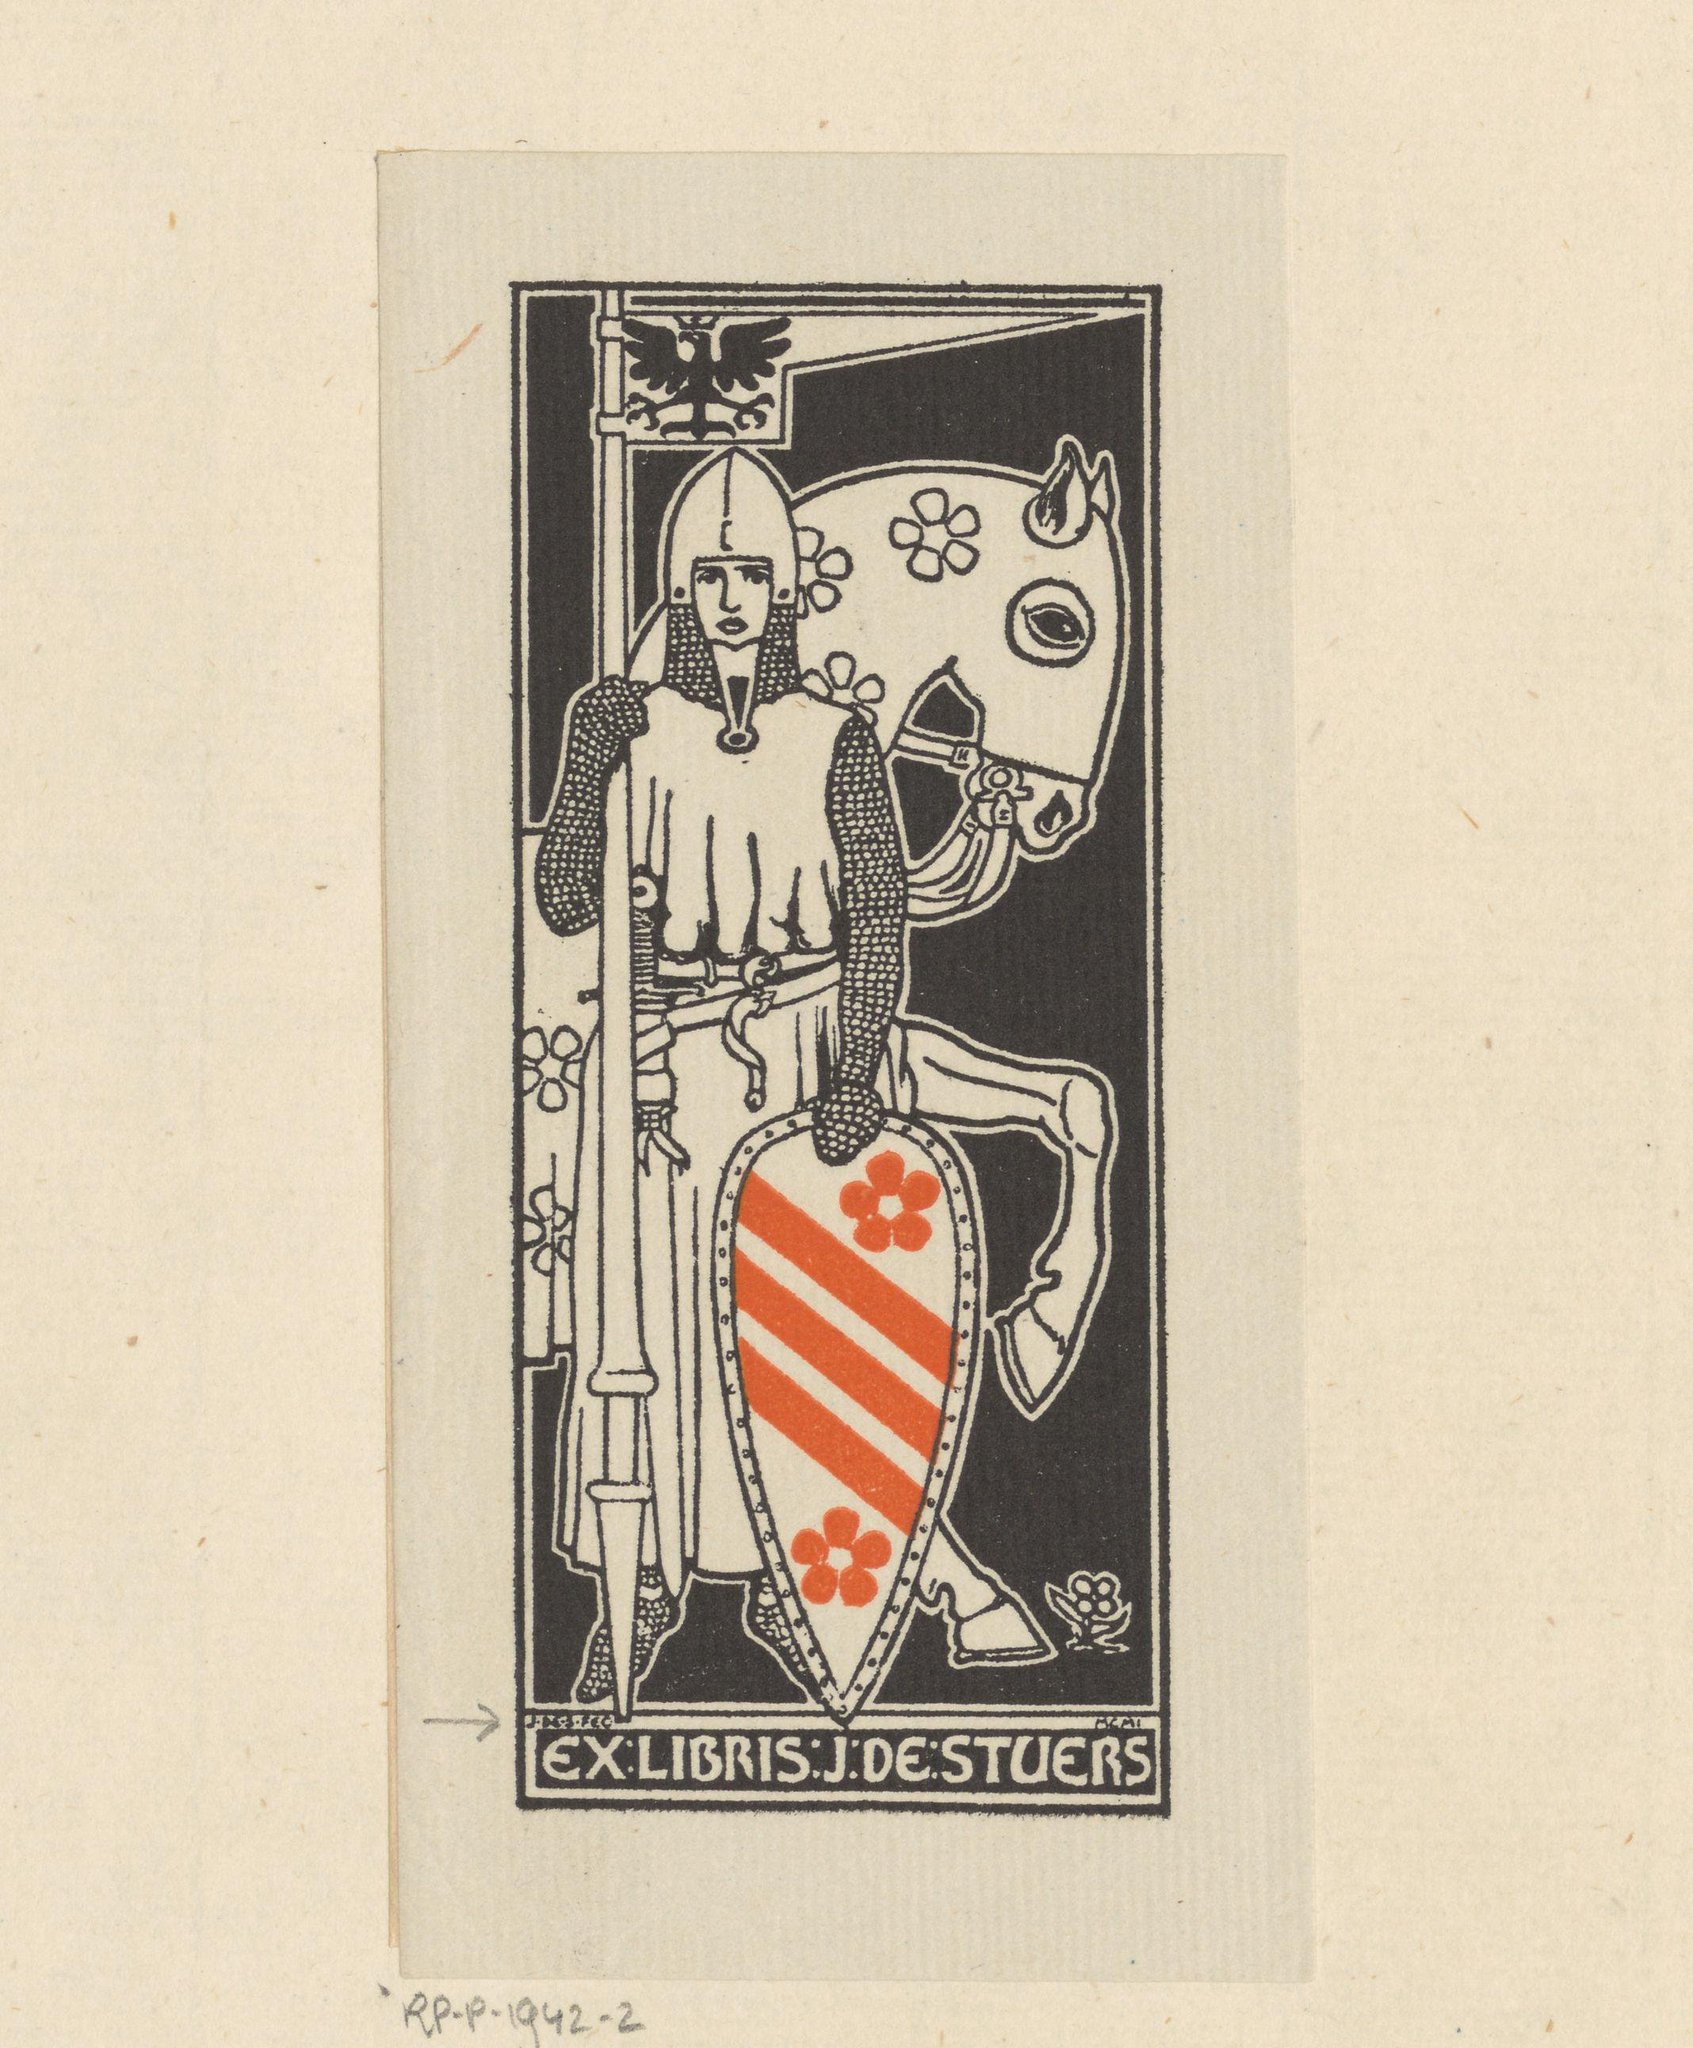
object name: bookplate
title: Ex libris van J. de Stuers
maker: jonkheer john hubert eugène françois de stuers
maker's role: print maker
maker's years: 1876-1907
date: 1901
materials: paper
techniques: printing block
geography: netherlands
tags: london, print maker, jonkheer john hubert eugène françois de stuers, horse, knight, armorial bearing, heraldry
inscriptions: date